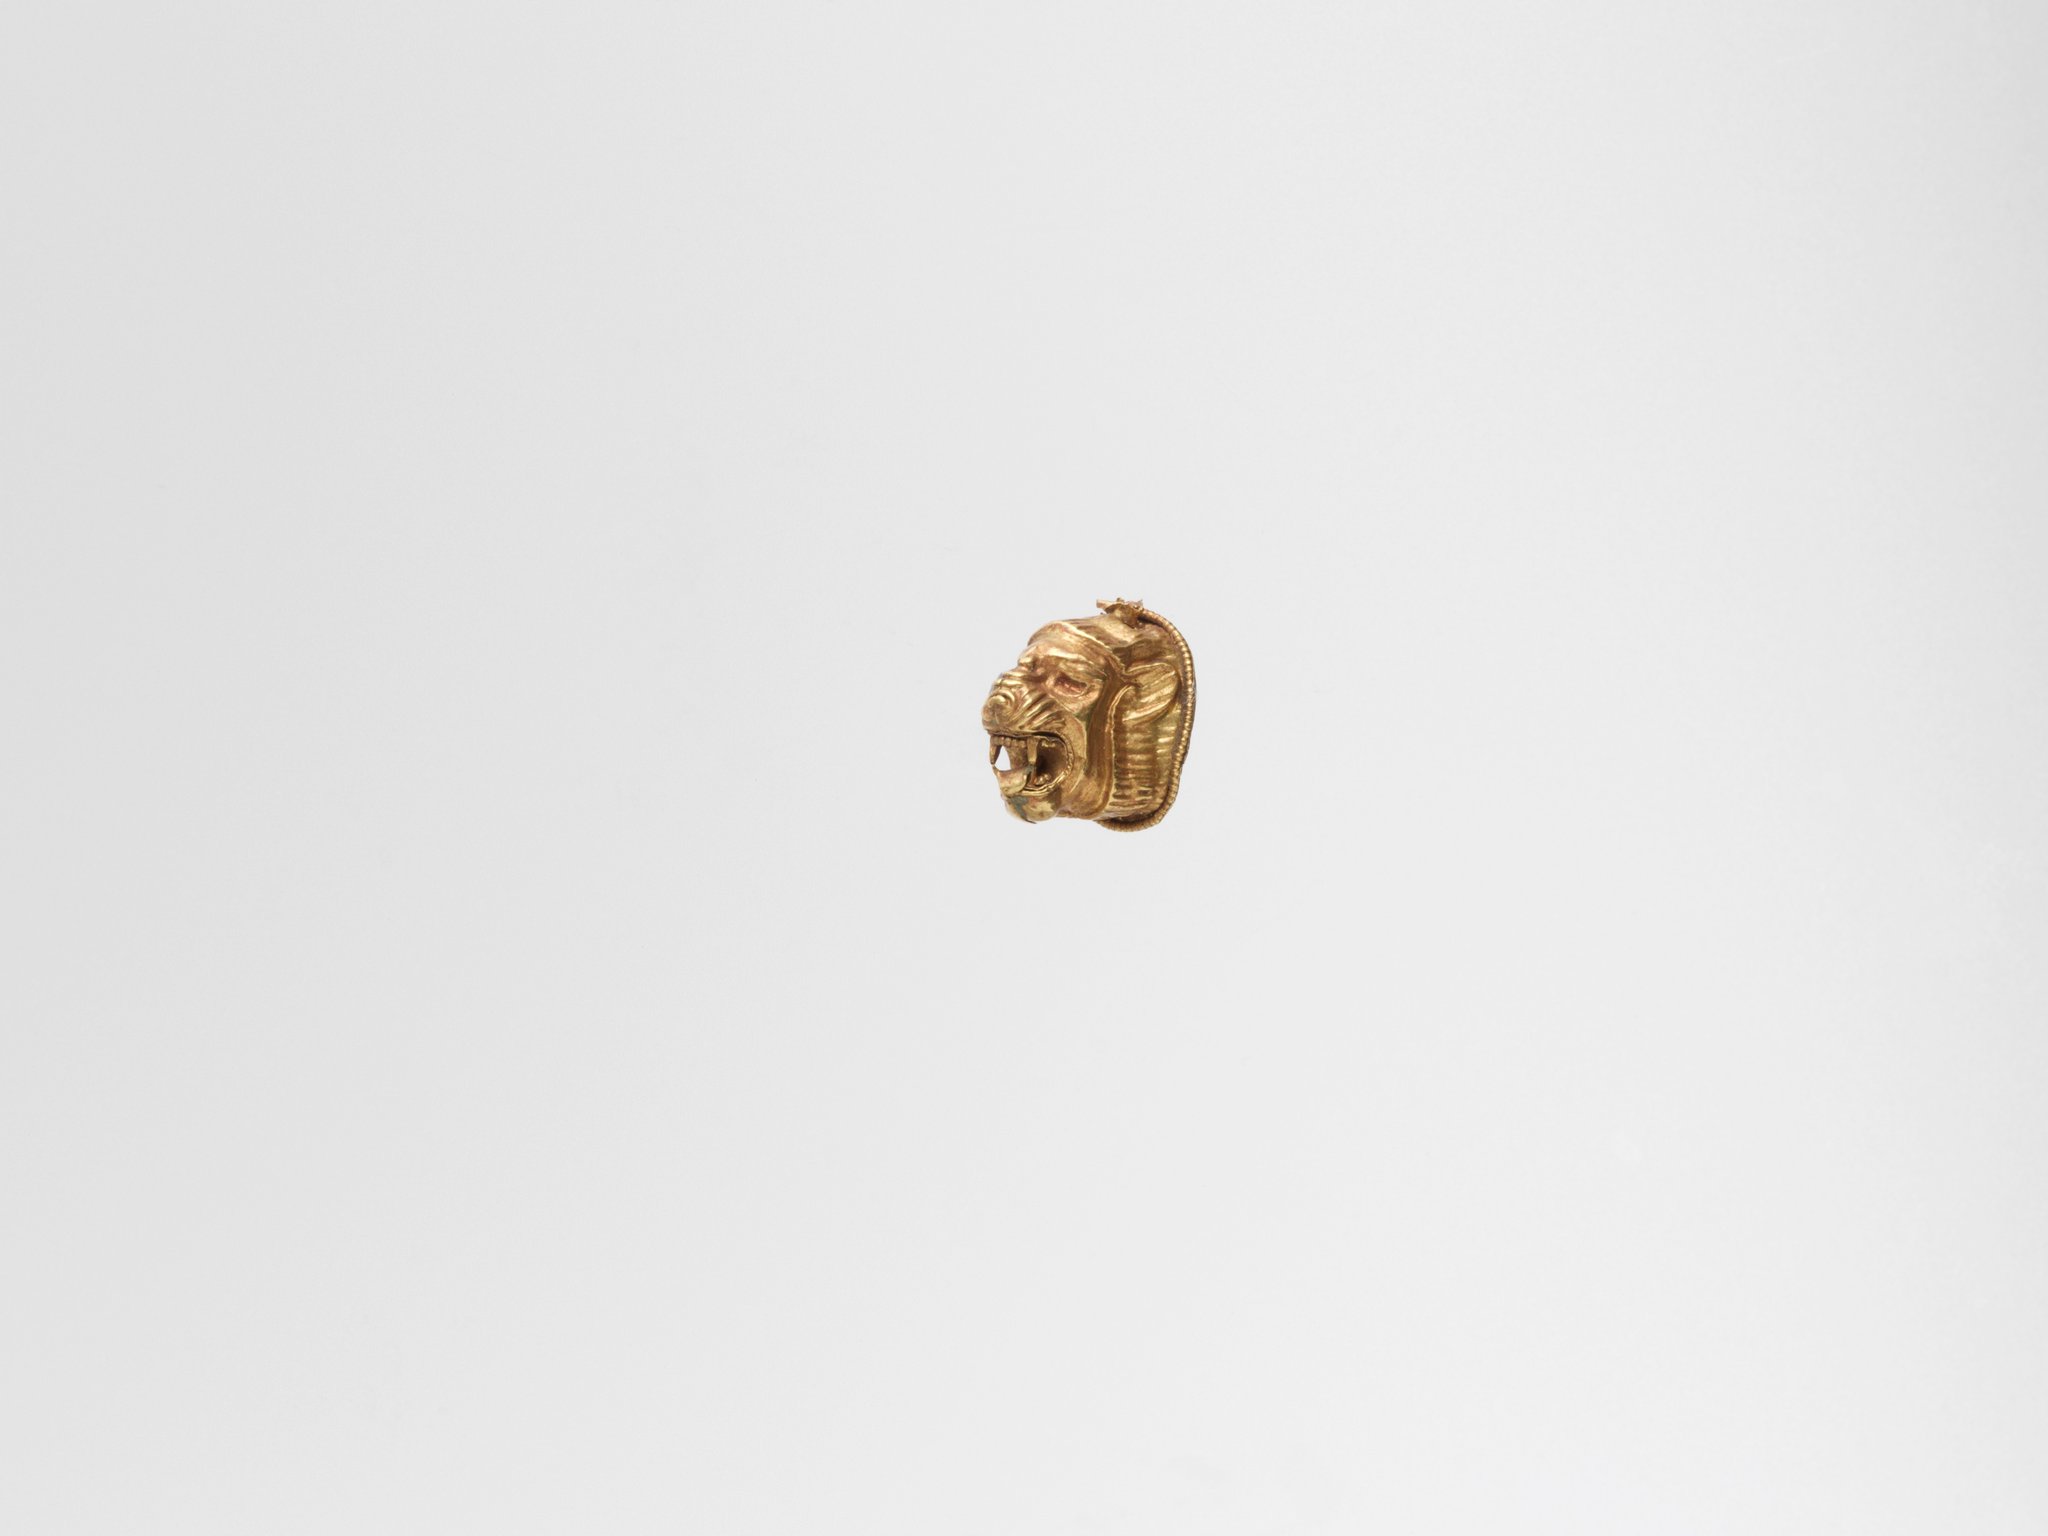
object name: pendant in the form of a lion's head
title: Gold pendant in the form of a lion's head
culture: cypriot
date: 450-400 BCE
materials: gold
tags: lions